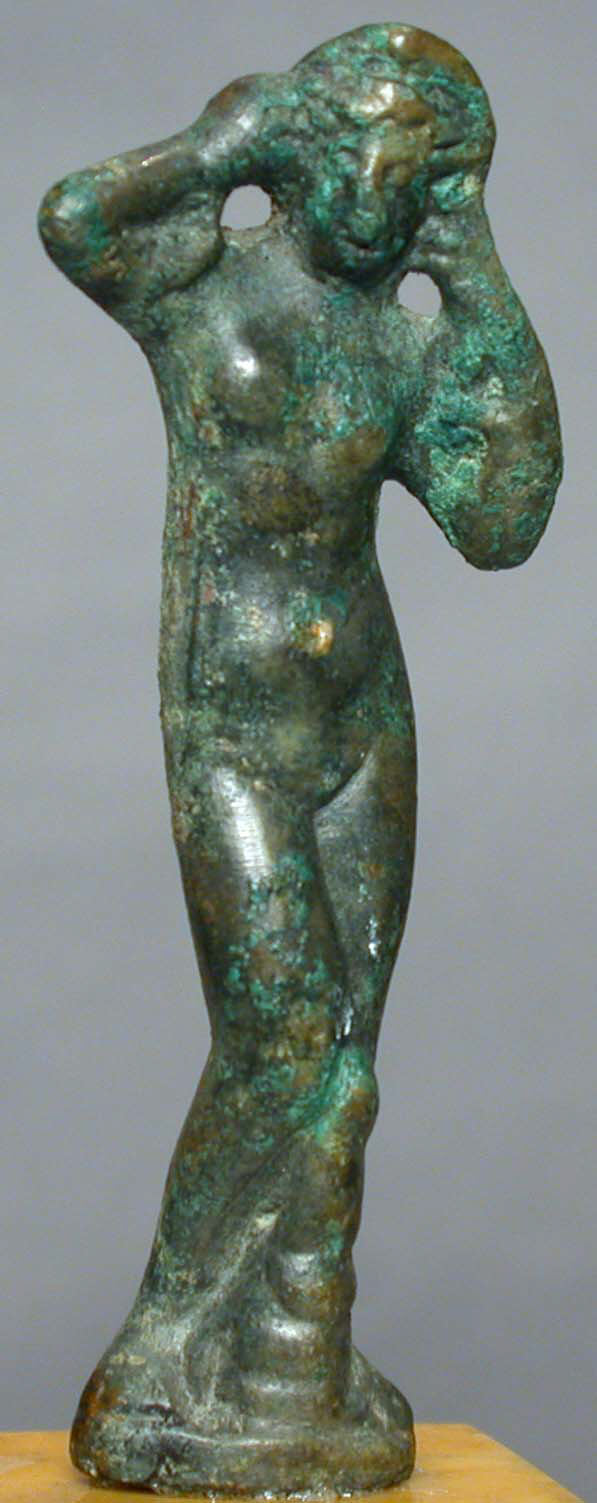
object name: statuette of aphrodite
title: Bronze statuette of Aphrodite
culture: roman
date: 1-200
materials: bronze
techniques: appliqué